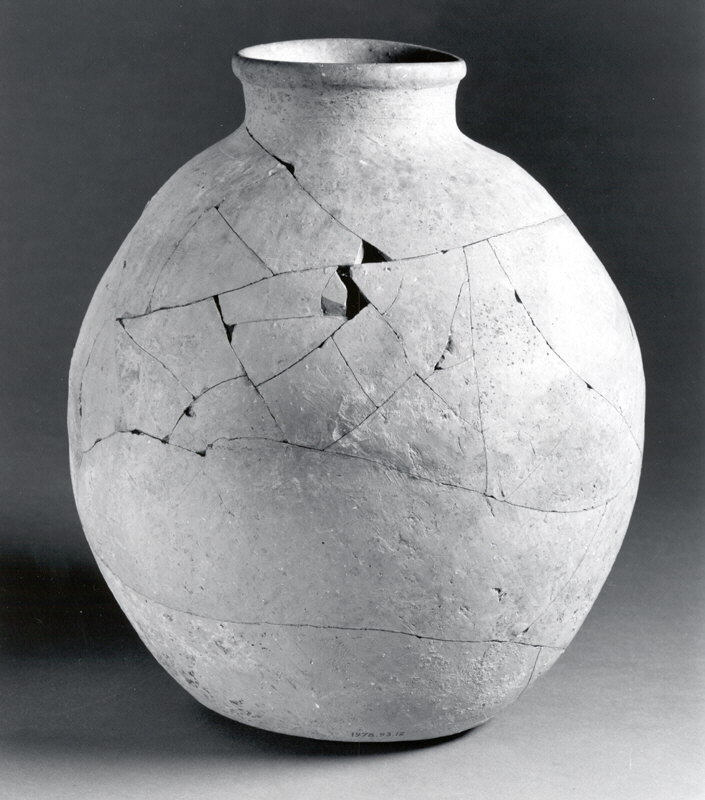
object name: jar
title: Storage jar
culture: seleucid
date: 400-201 BCE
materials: ceramic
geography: iran